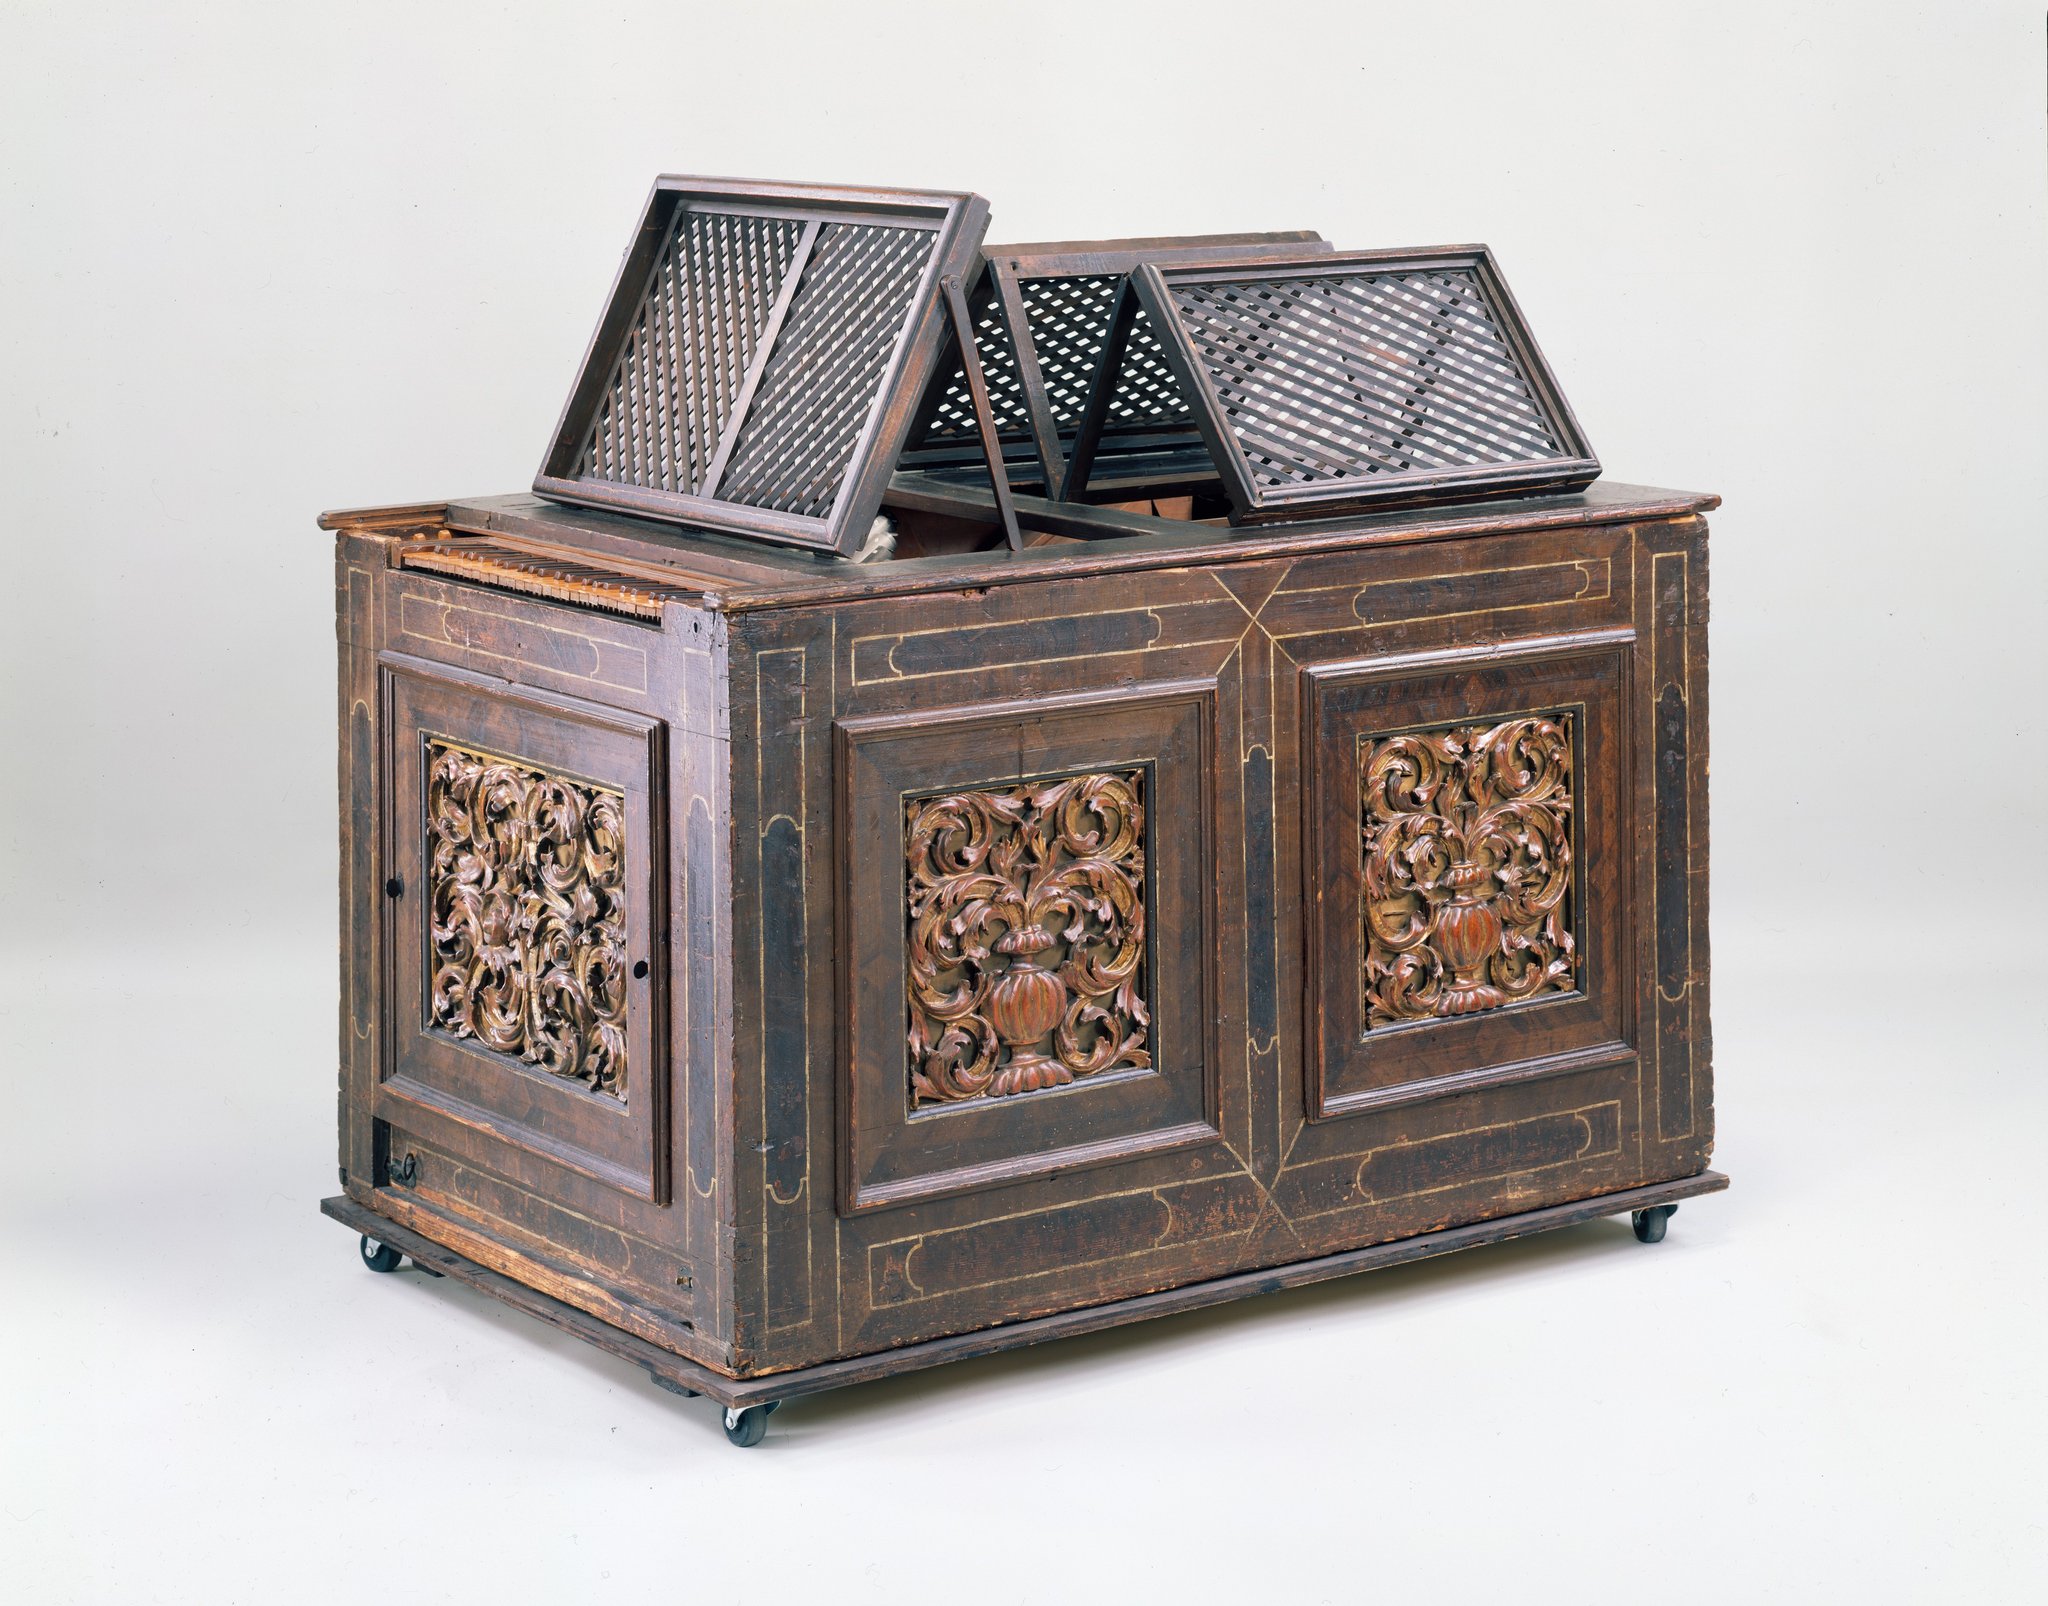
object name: positive organ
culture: german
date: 1601-1700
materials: leather, metal, wood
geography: germany